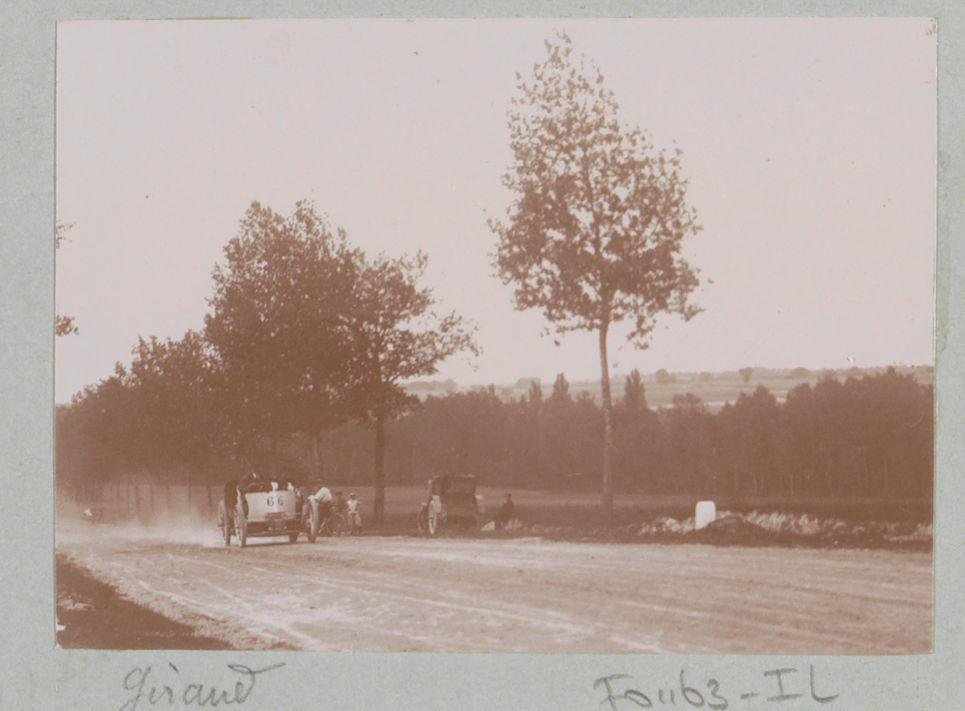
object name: photograph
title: Autocoureur Giraud, deelnemer aan de Tour de France voor automobielen, op een landweg in Vitry-le-François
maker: delizy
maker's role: manufacturer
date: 1899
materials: paper, photographic support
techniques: gelatin silver print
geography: vitry-le-françois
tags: automobile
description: Onderdeel van Fotoalbum van een Franse amateurfotograaf met opnames van uitstapjes in Frankrijk, Spanje, België, Luxemburg en Nederland, de eerste automobielen en autoraces.